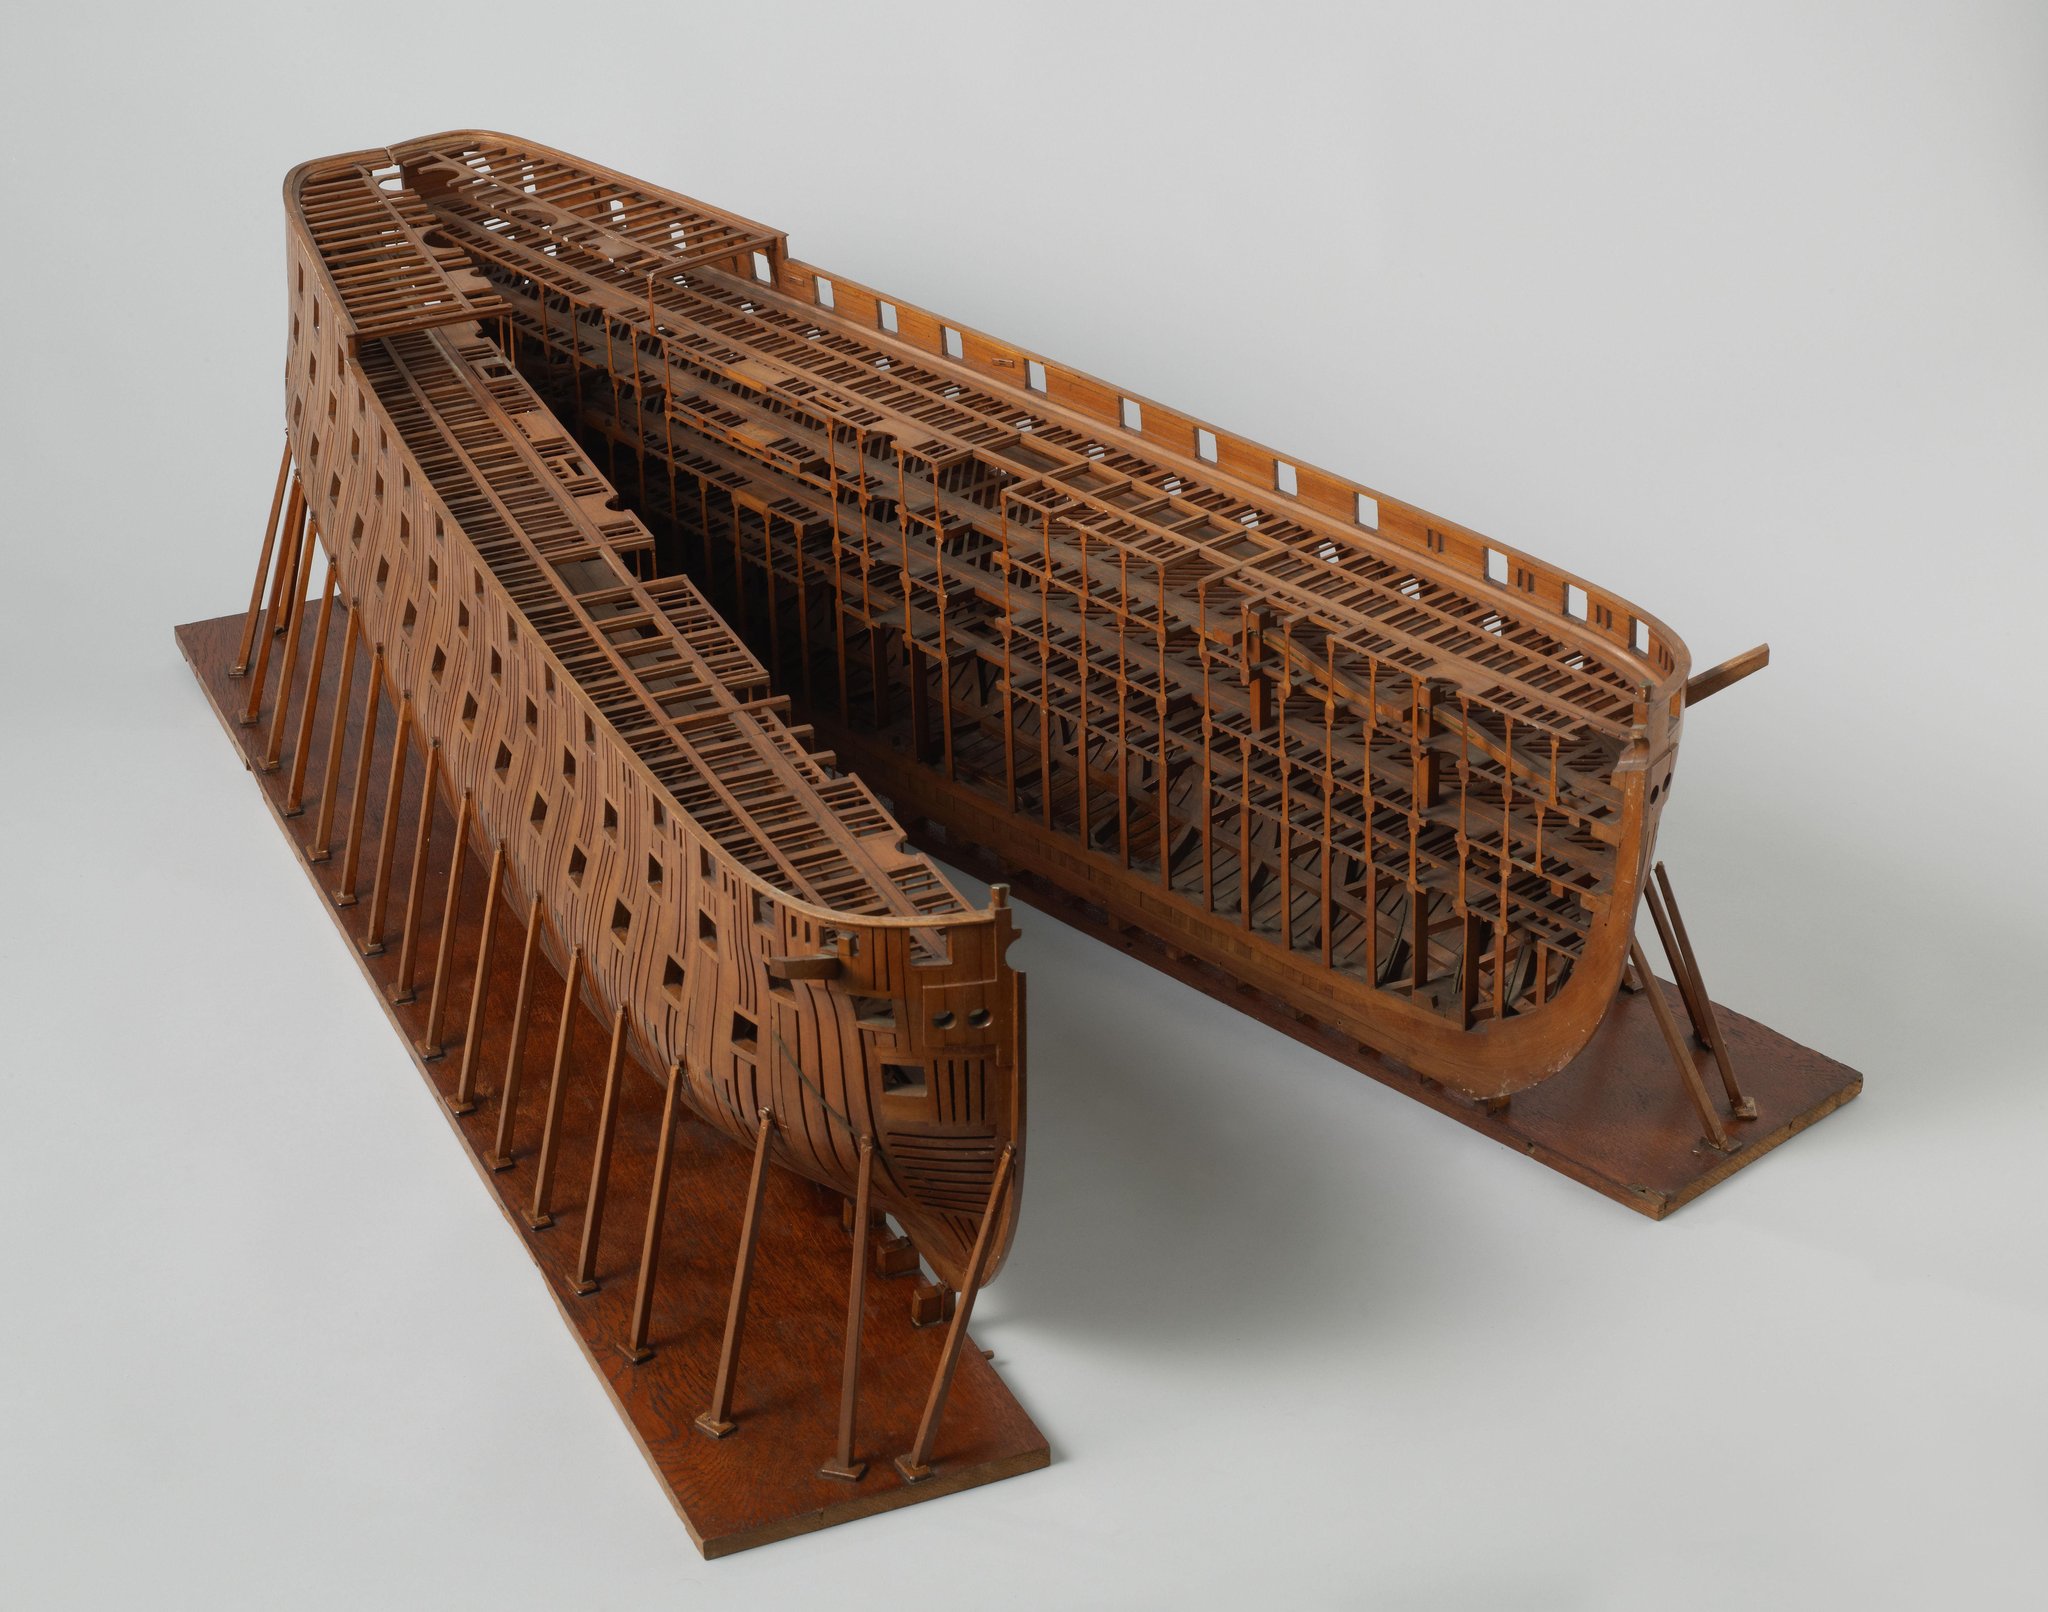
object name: demonstration model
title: Model of a 74-Gun Ship of the Line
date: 1833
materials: brass, wood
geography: flushing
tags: de ruyter (schip)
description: Constructiemodel, in de lengte verticaal doorgesneden, de helften steunend op schoren op een grondplank. Spantmodel zonder huid of beschieting, bedoeld om de verschillen in de constructie van kruisverband volgens Sir Robert Seppings (bakboordhelft) en Cornelis Soetermeer (stuurboordhelft) te laten zien. Bij Soetermeer's systeem zijn de trekkende delen van Seppings' kruisverband uit het ruim weggelaten en vervangen door metalen strips buiten op de inhouten onder de huid. Aan bakboord heeft het voorschip alleen verticale vulstukken, aan stuurboord zijn horizontale banden aangebracht. Rond achterschip met wulf en hek van twee verdiepingen, zonder details of zijgalerijen. Zes en negentig geschutpoorten verdeeld over drie dekken. Vijf dekken: koebrugdek, onder-, tussen- en bovendek en bovenkampanje: onder- en tussendek hebben een diagonale schering in het web, de dekbalken van alle dekken behalve de koebrug worden gesteund door messing knieën. De zeeg loopt iets op aan beide uiteinden, geen barkhouten of reehout. Gepiekt rondspant, achter scherp weggesneden. Schaal 1:50 (afgeleid).